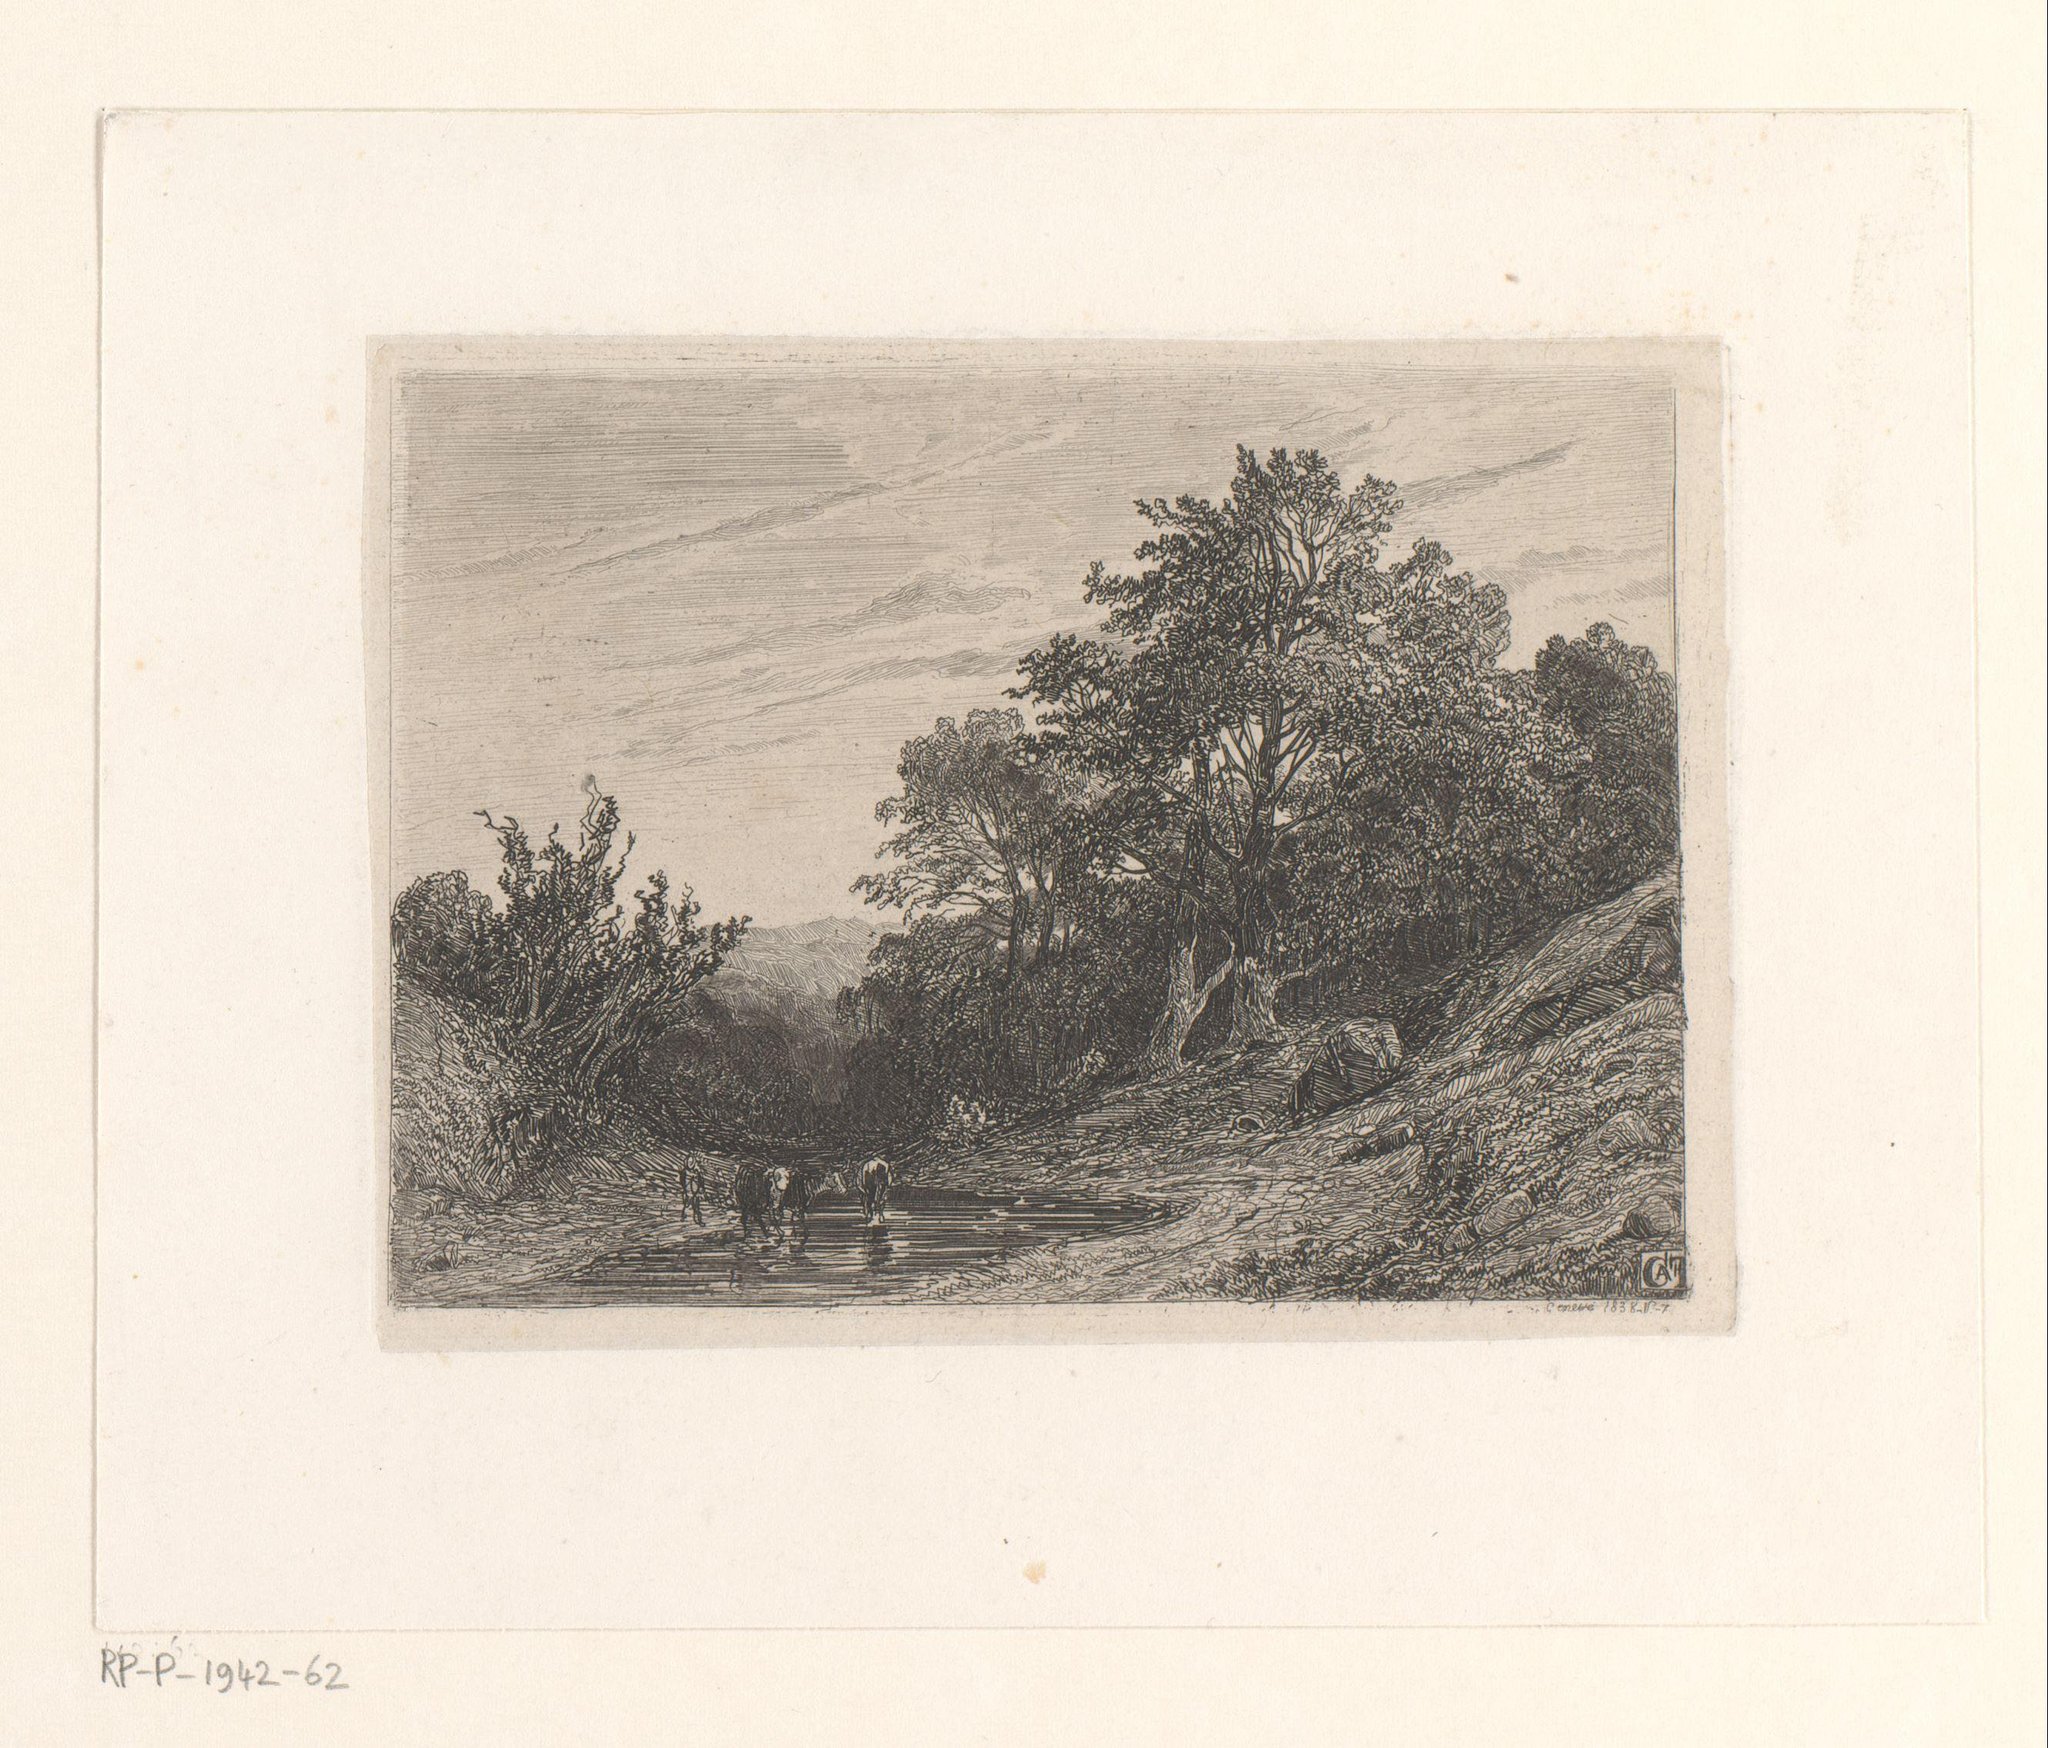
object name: print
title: Berglandschap met koeien bij een beek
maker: alexandre calame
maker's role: draughtsman, painter, print maker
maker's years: 1810-1864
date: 1838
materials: paper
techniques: etching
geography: geneva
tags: cow, brook, mountains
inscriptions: collector's mark: Lugt 2228, collector's mark: Lugt 2760